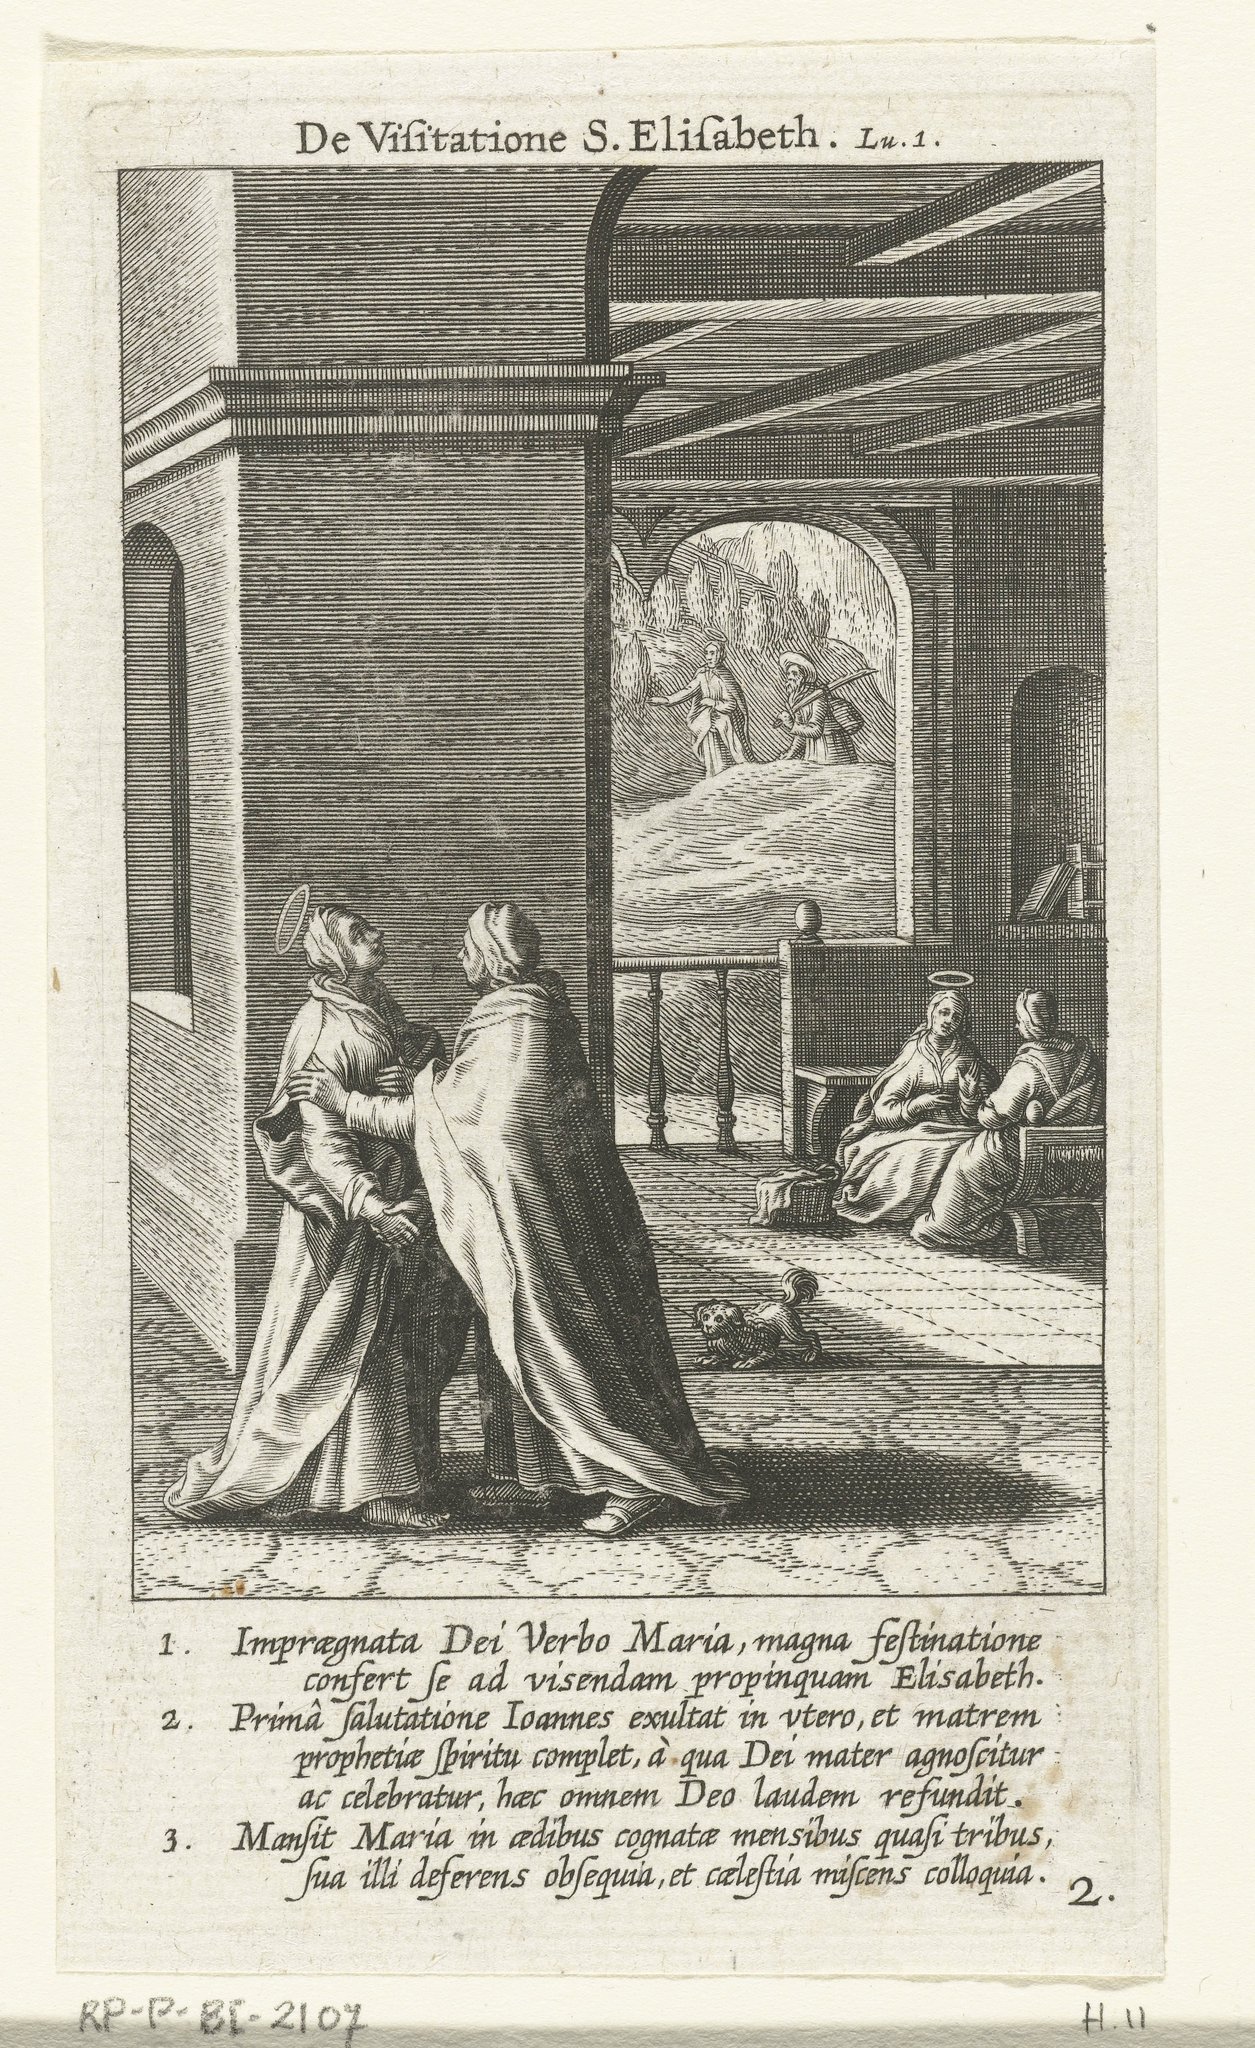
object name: print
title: Vitae passionis et mortis Jesu Christ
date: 1590-1622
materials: paper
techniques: engraving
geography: antwerp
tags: visitation (possibly joseph and/or zacharias present) (luke 1:39-56)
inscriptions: collector's mark: Lugt 240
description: Prent uit: Joannes Bourgois, Vitae passionis et mortis Jesu Christi Somini nostri mysteria, Antwerpen Hendrick Aertssens, 1622, afb. 2